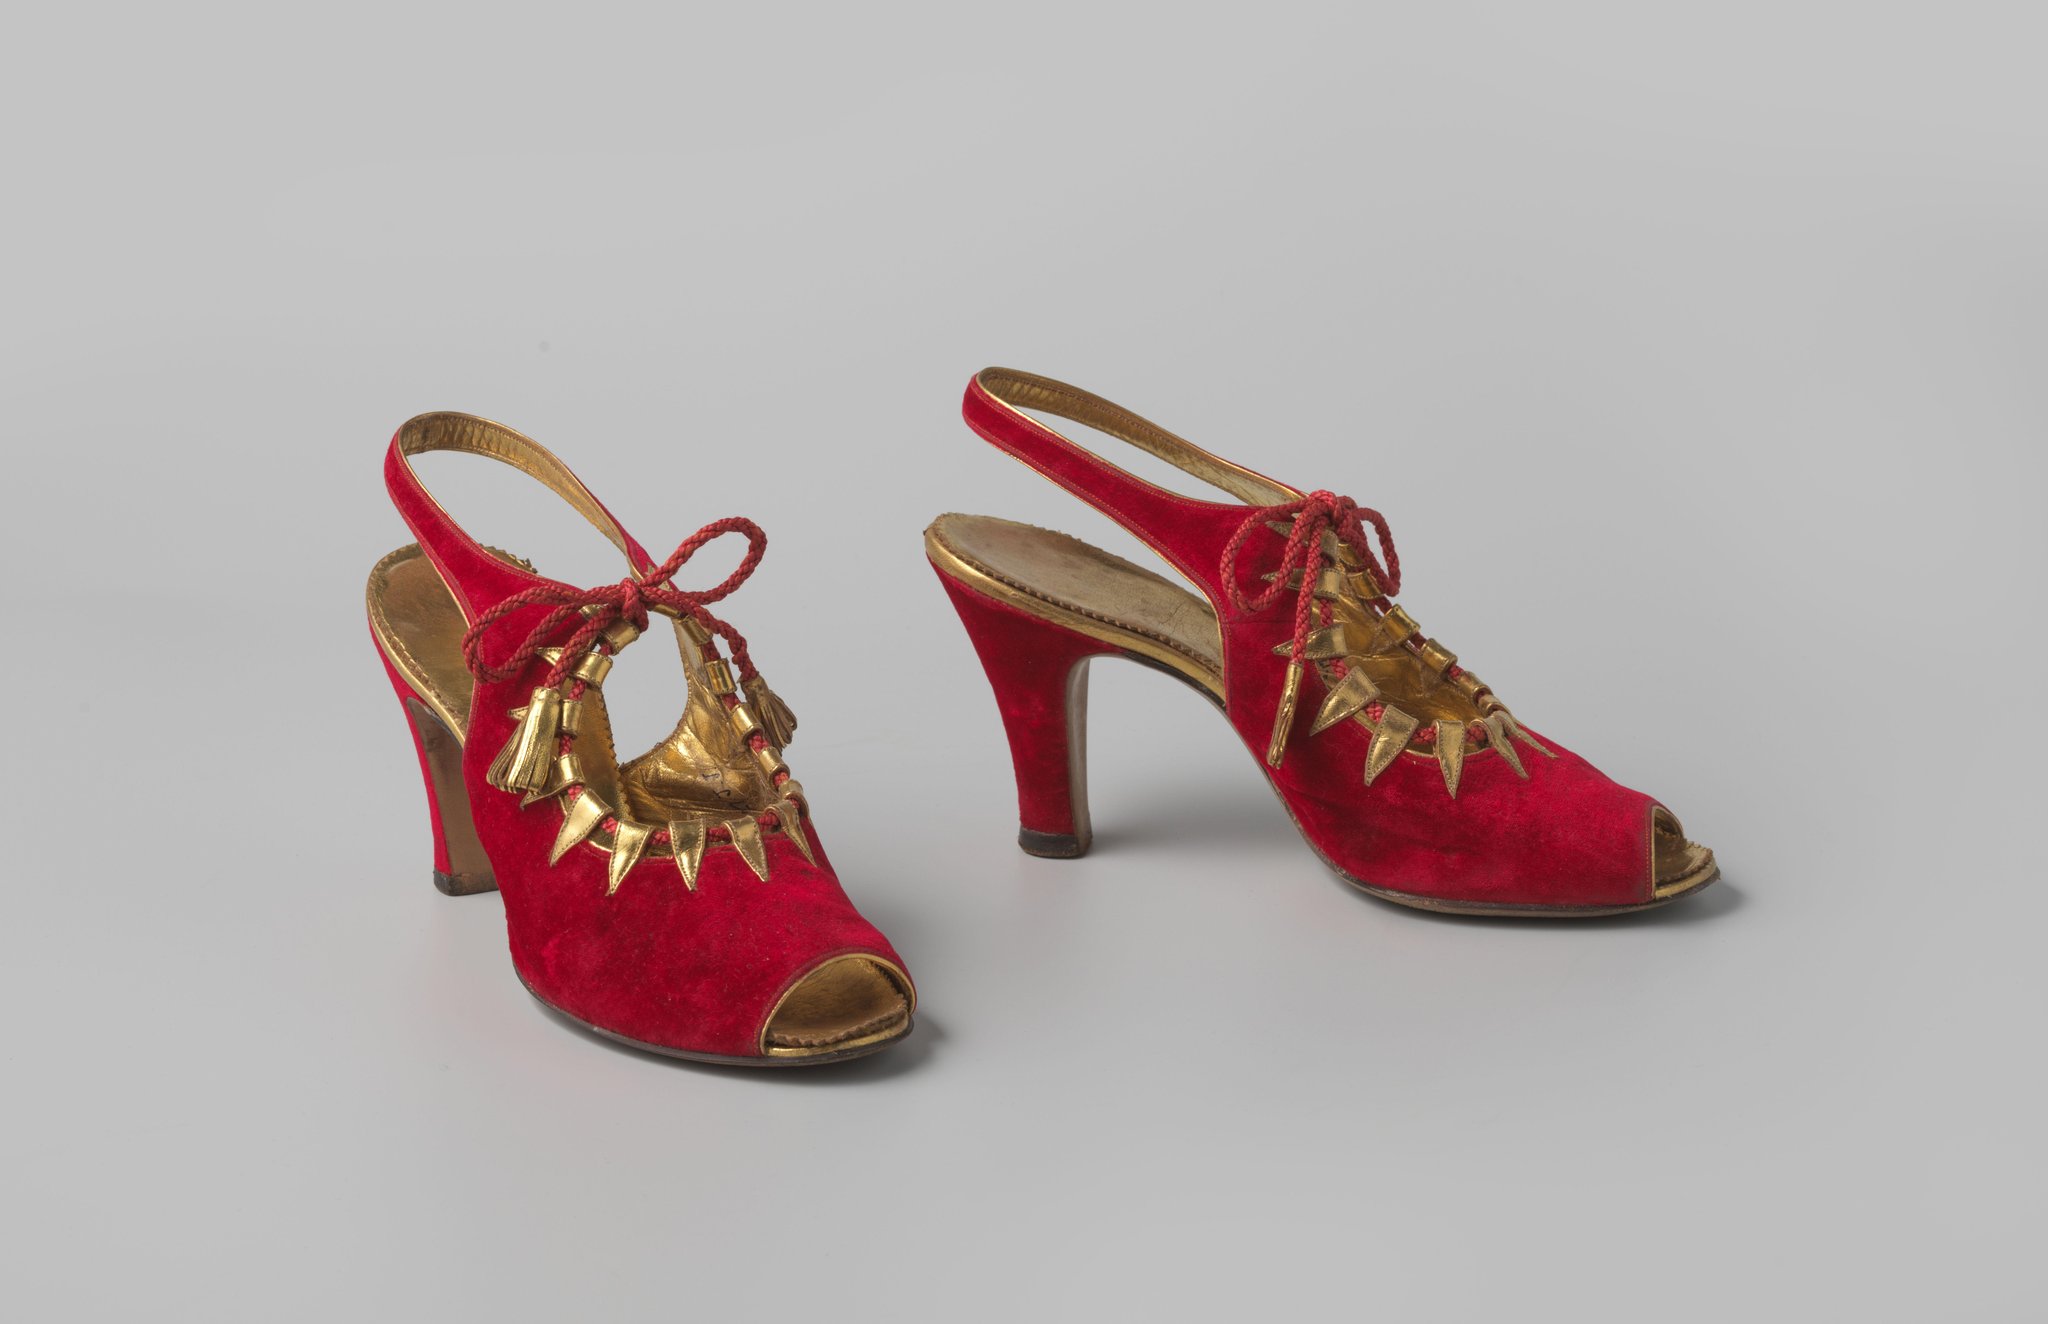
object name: shoe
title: Damesschoenen (avondschoen) van rood fluweel afgezet met goudkleurig leer (links)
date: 1930-1940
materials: cotton, leather, silk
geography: london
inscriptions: : ‘27 J.J. / 5.B./8021./5350.3’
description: Linkerschoen van paar damesschoenen (avondschoenen) van rood fluweel afgezet met goudkleurig leer. Model: open teen en hiel, sluiting met rood koord met goudkleurige leren franjes, gevoerd met goudkleurig leer.